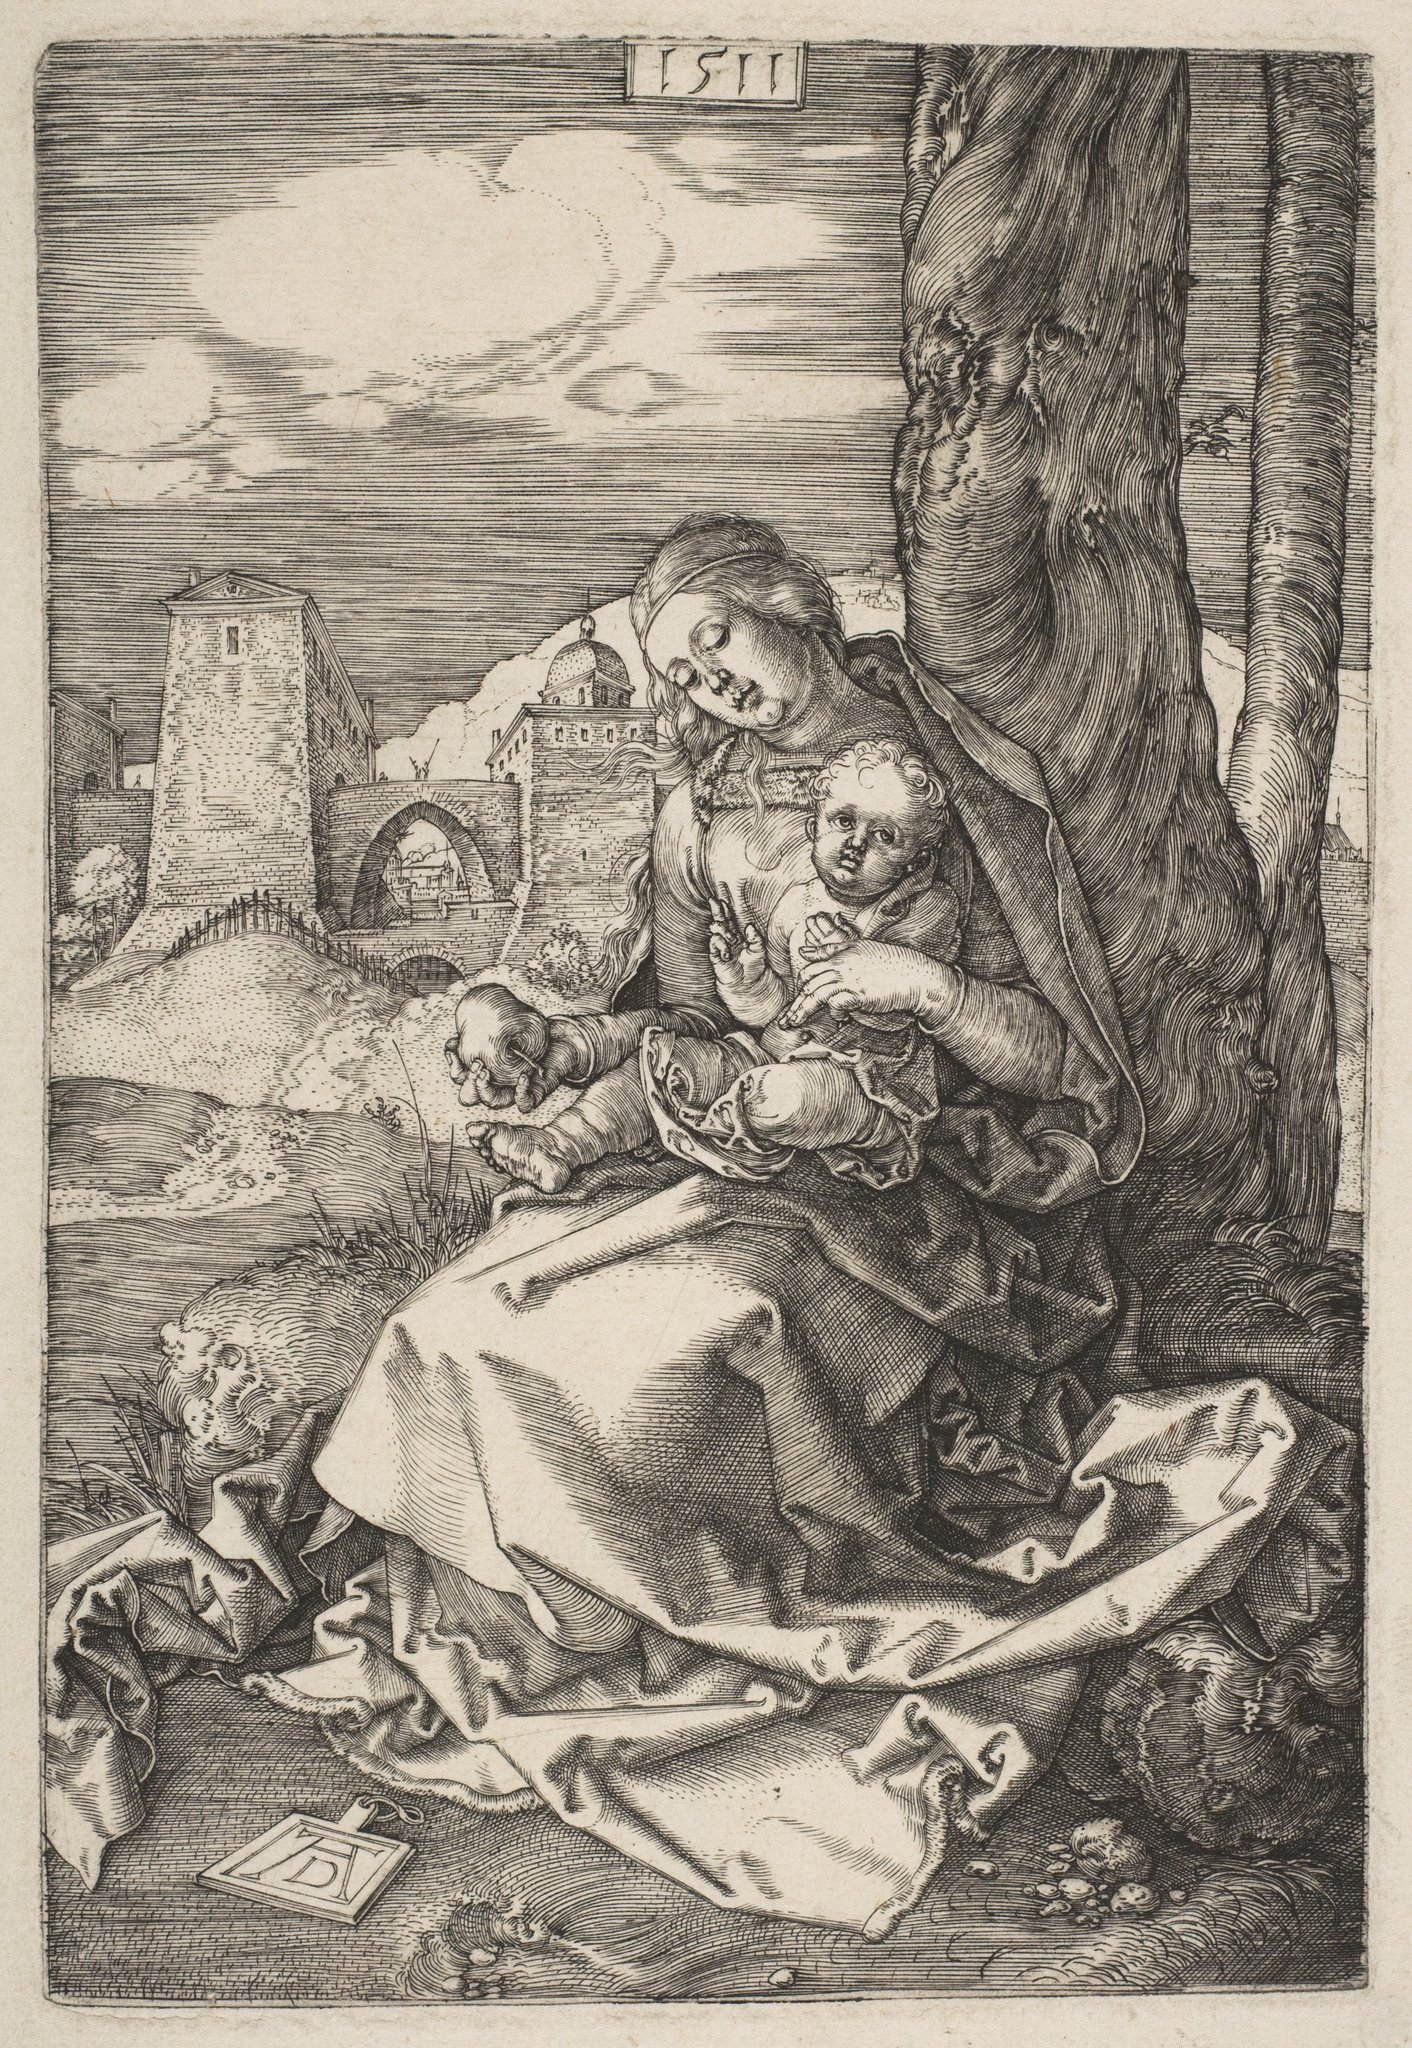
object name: print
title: Virgin and Child with the Pear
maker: albrecht dürer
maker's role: artist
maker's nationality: german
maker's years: 1471-1528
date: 1511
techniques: engraving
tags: pears,madonna and child